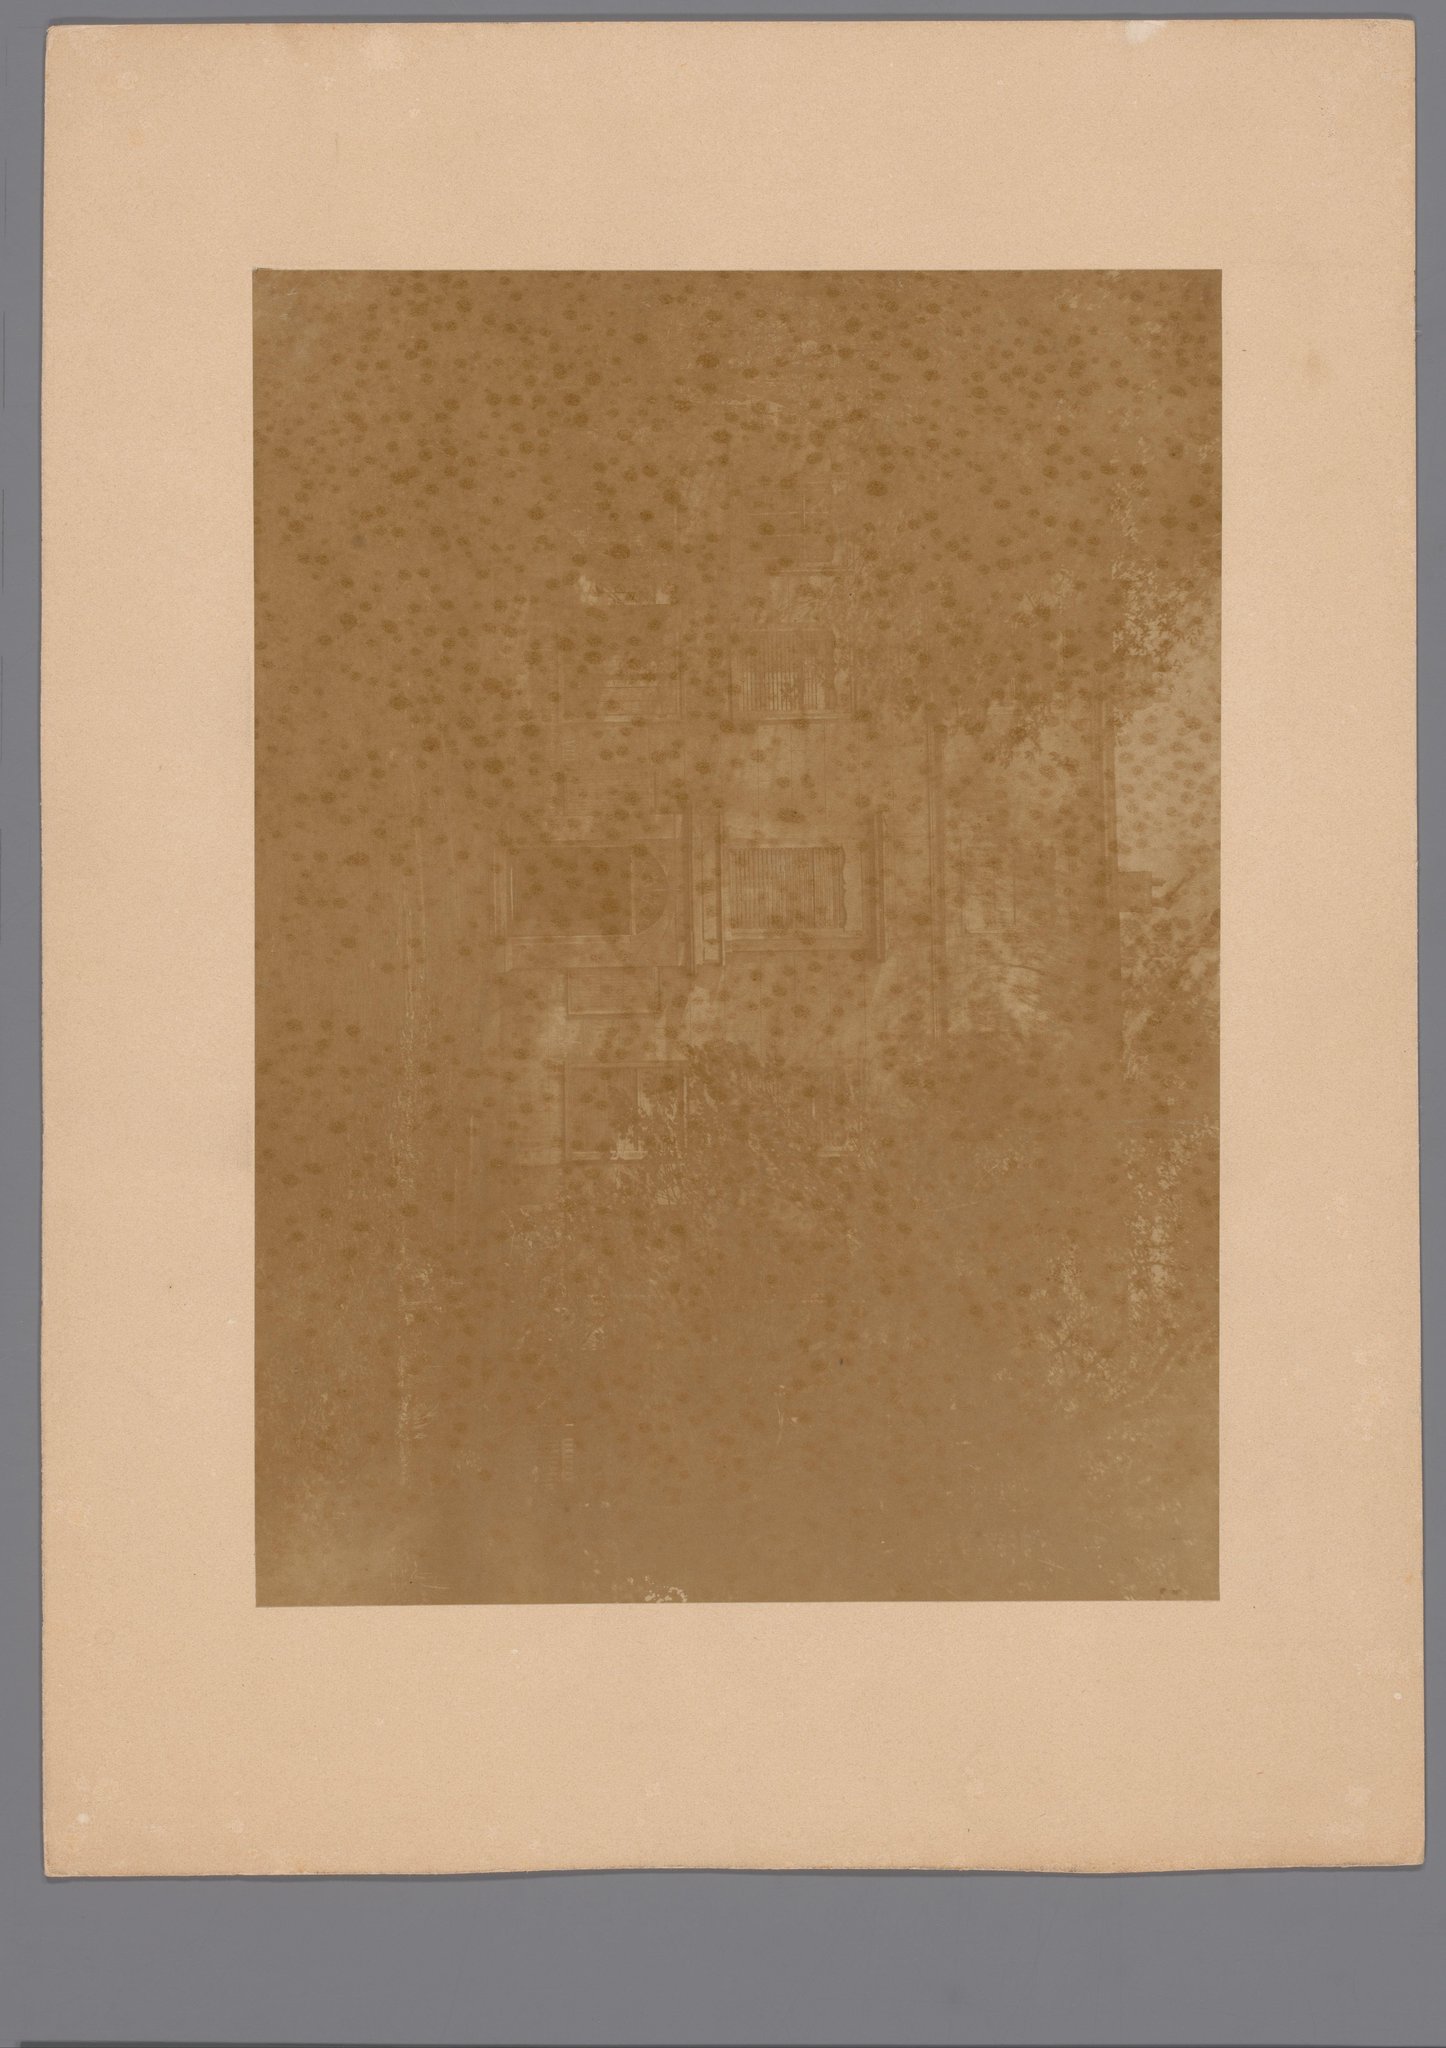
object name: photograph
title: Gezicht op het Buitengasthuis te Amsterdam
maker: anoniem (monumentenzorg)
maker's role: fotograaf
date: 1900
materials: cardboard, photographic support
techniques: albumen print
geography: amsterdam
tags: hospital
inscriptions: annotation: ‘Buitengasthuis te Amsterdam’